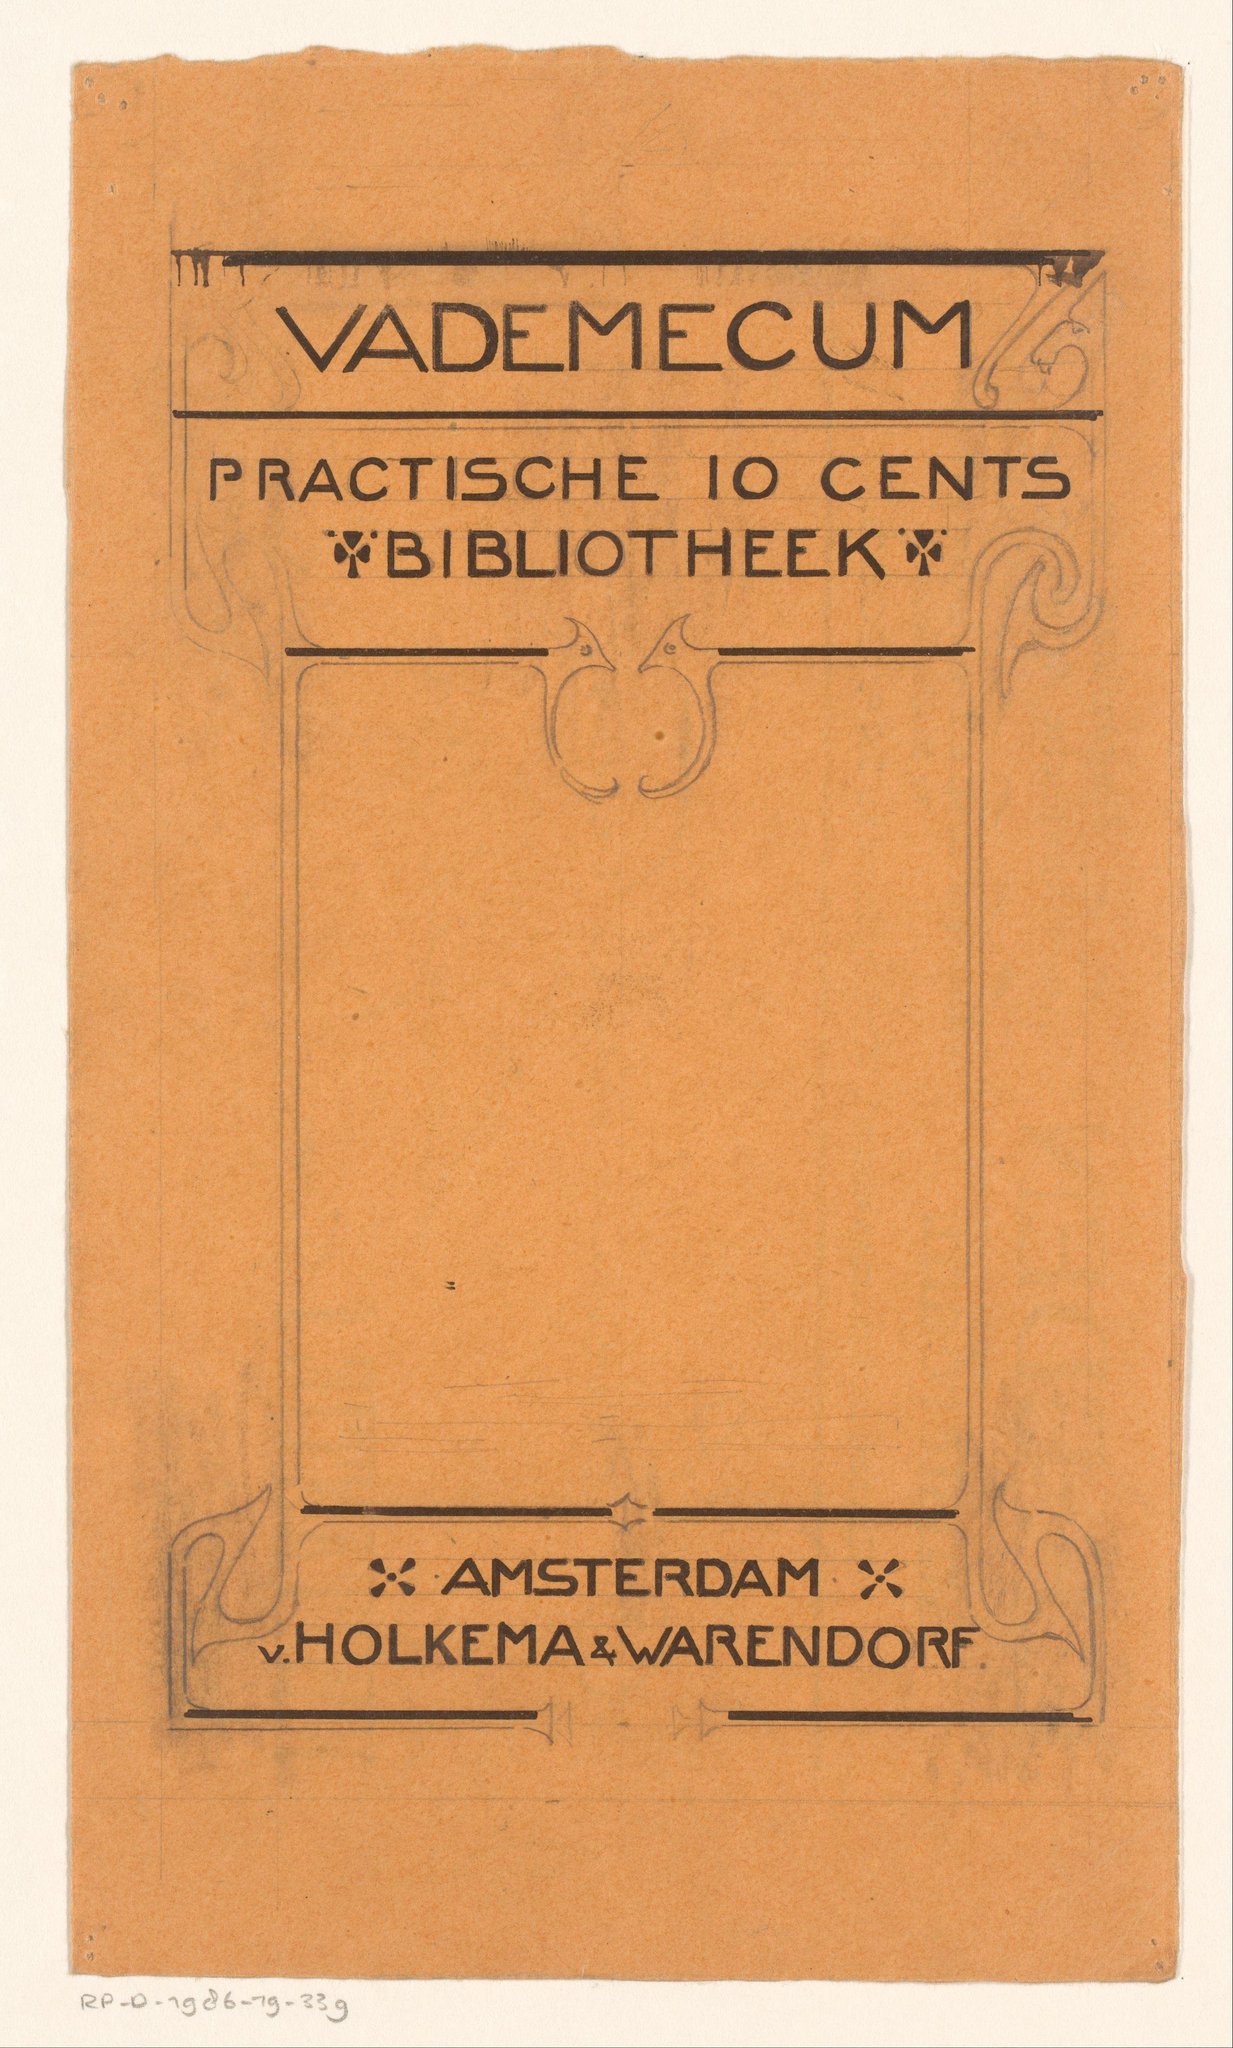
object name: design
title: Omslagontwerp voor: Vademecum. Praktische 10 cents bibliotheek, 1903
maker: reinier willem petrus de vries (1874-1953)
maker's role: draughtsman, print maker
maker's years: 1874-1953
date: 1903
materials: ink, paper, pencil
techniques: brush, pen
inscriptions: collector's mark: ‘R:MVS.’, inscription: ‘Mevrouw de Vries/ Singel 146/ 16 Oct’